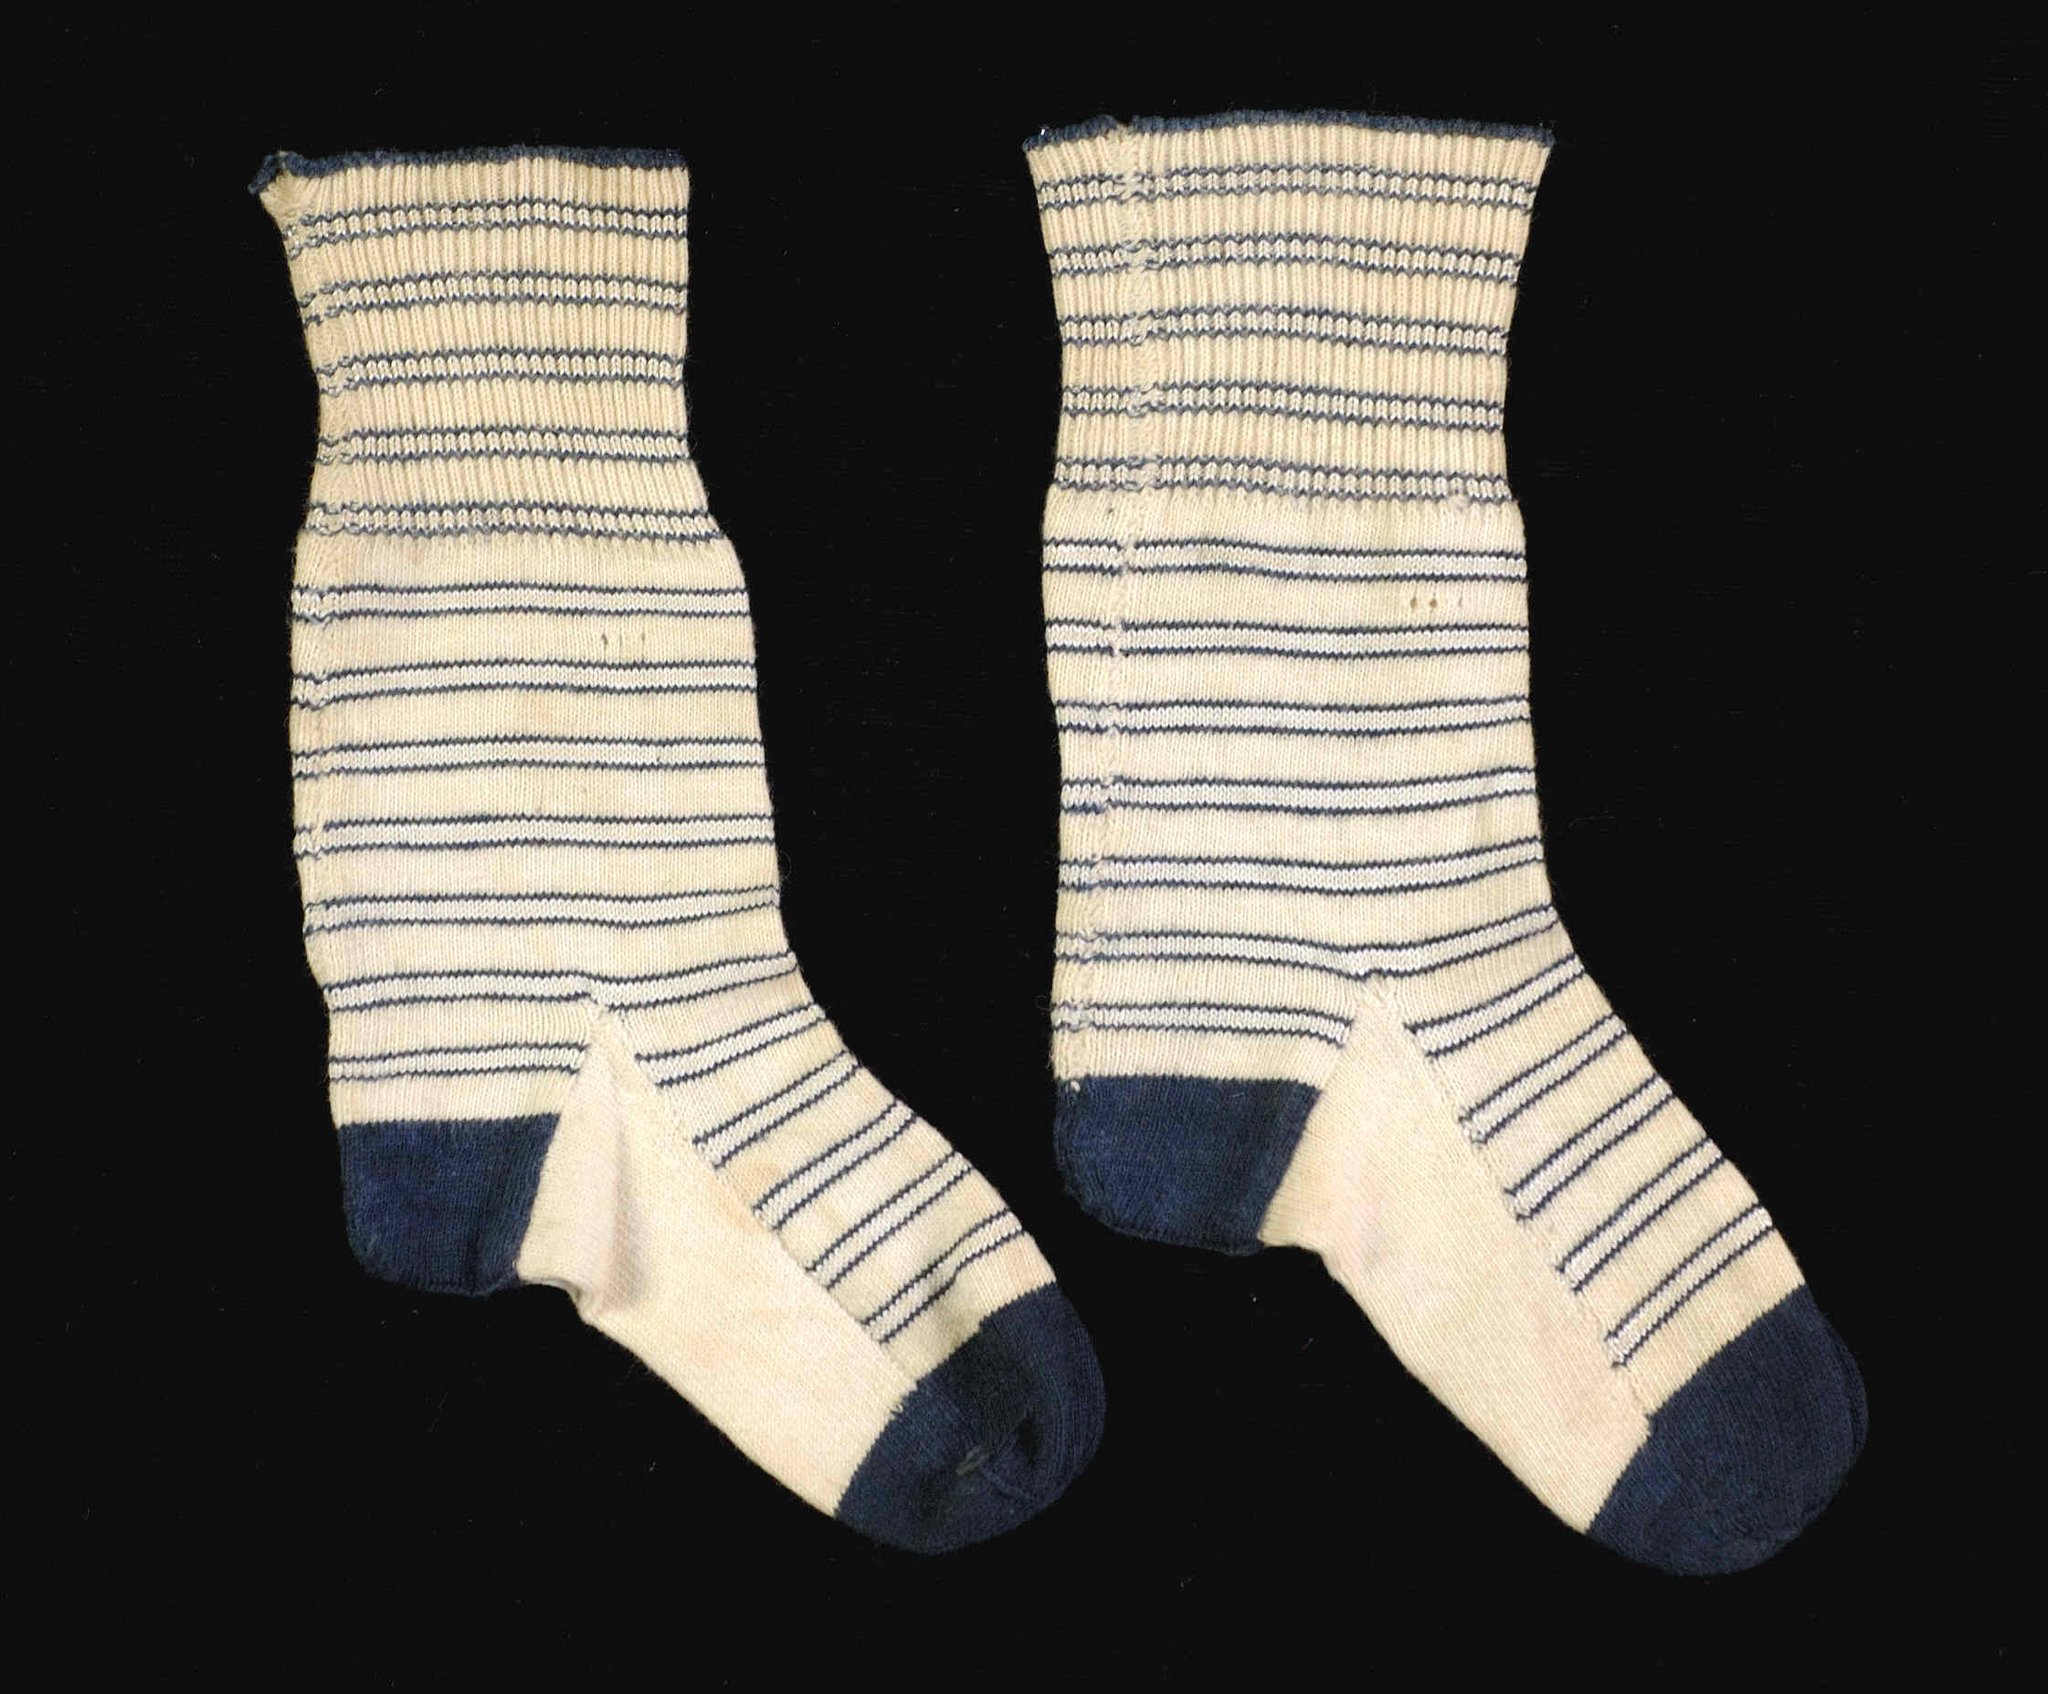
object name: stocking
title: Stockings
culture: american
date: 1876-1900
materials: cotton